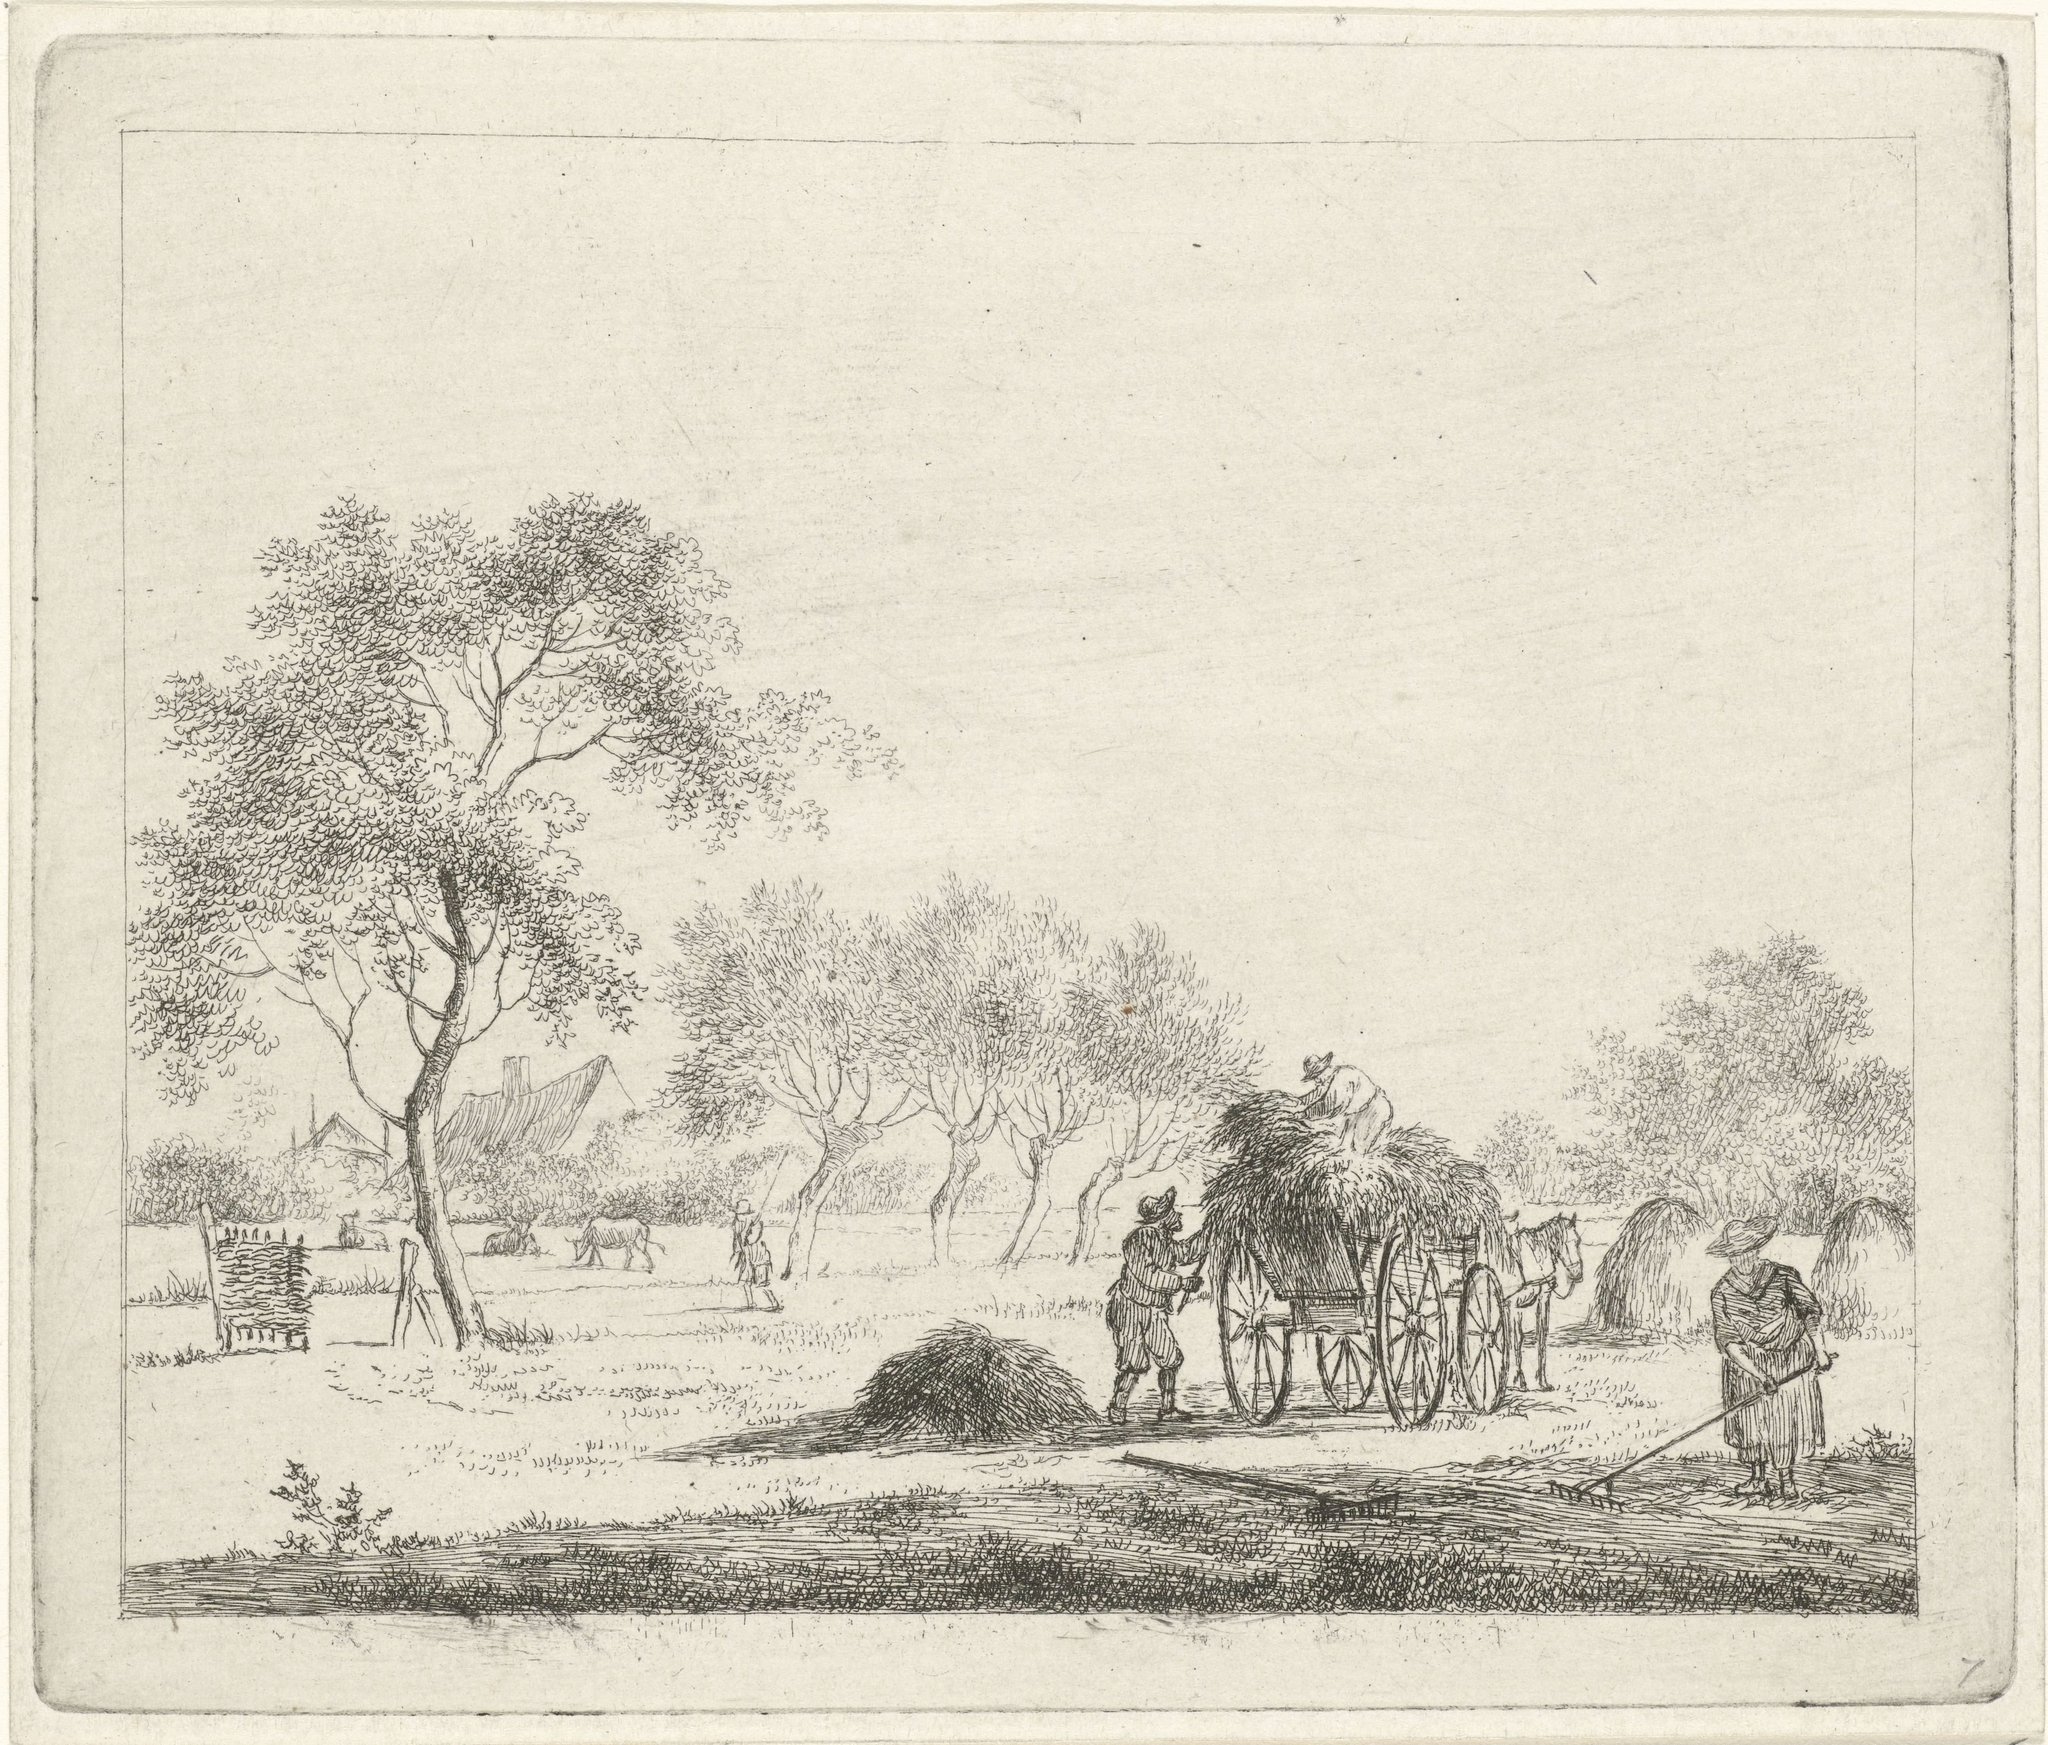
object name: print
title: Juli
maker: johannes janson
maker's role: draughtsman, painter, print maker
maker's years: 1729-1784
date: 1783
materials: paper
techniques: etching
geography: leiden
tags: hay-wagon (+ labourers ~ crafts, industries, agriculture), landscape symbolizing july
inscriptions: collector's mark: Lugt 2228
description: Landschap met op de voorgrond een hooiwagen met twee boeren en een boerin met hark. Links op de achtergrond een boerderij, koeien en een boer. Vóór de lucht. Achtste prent uit een serie van dertien met maanden.